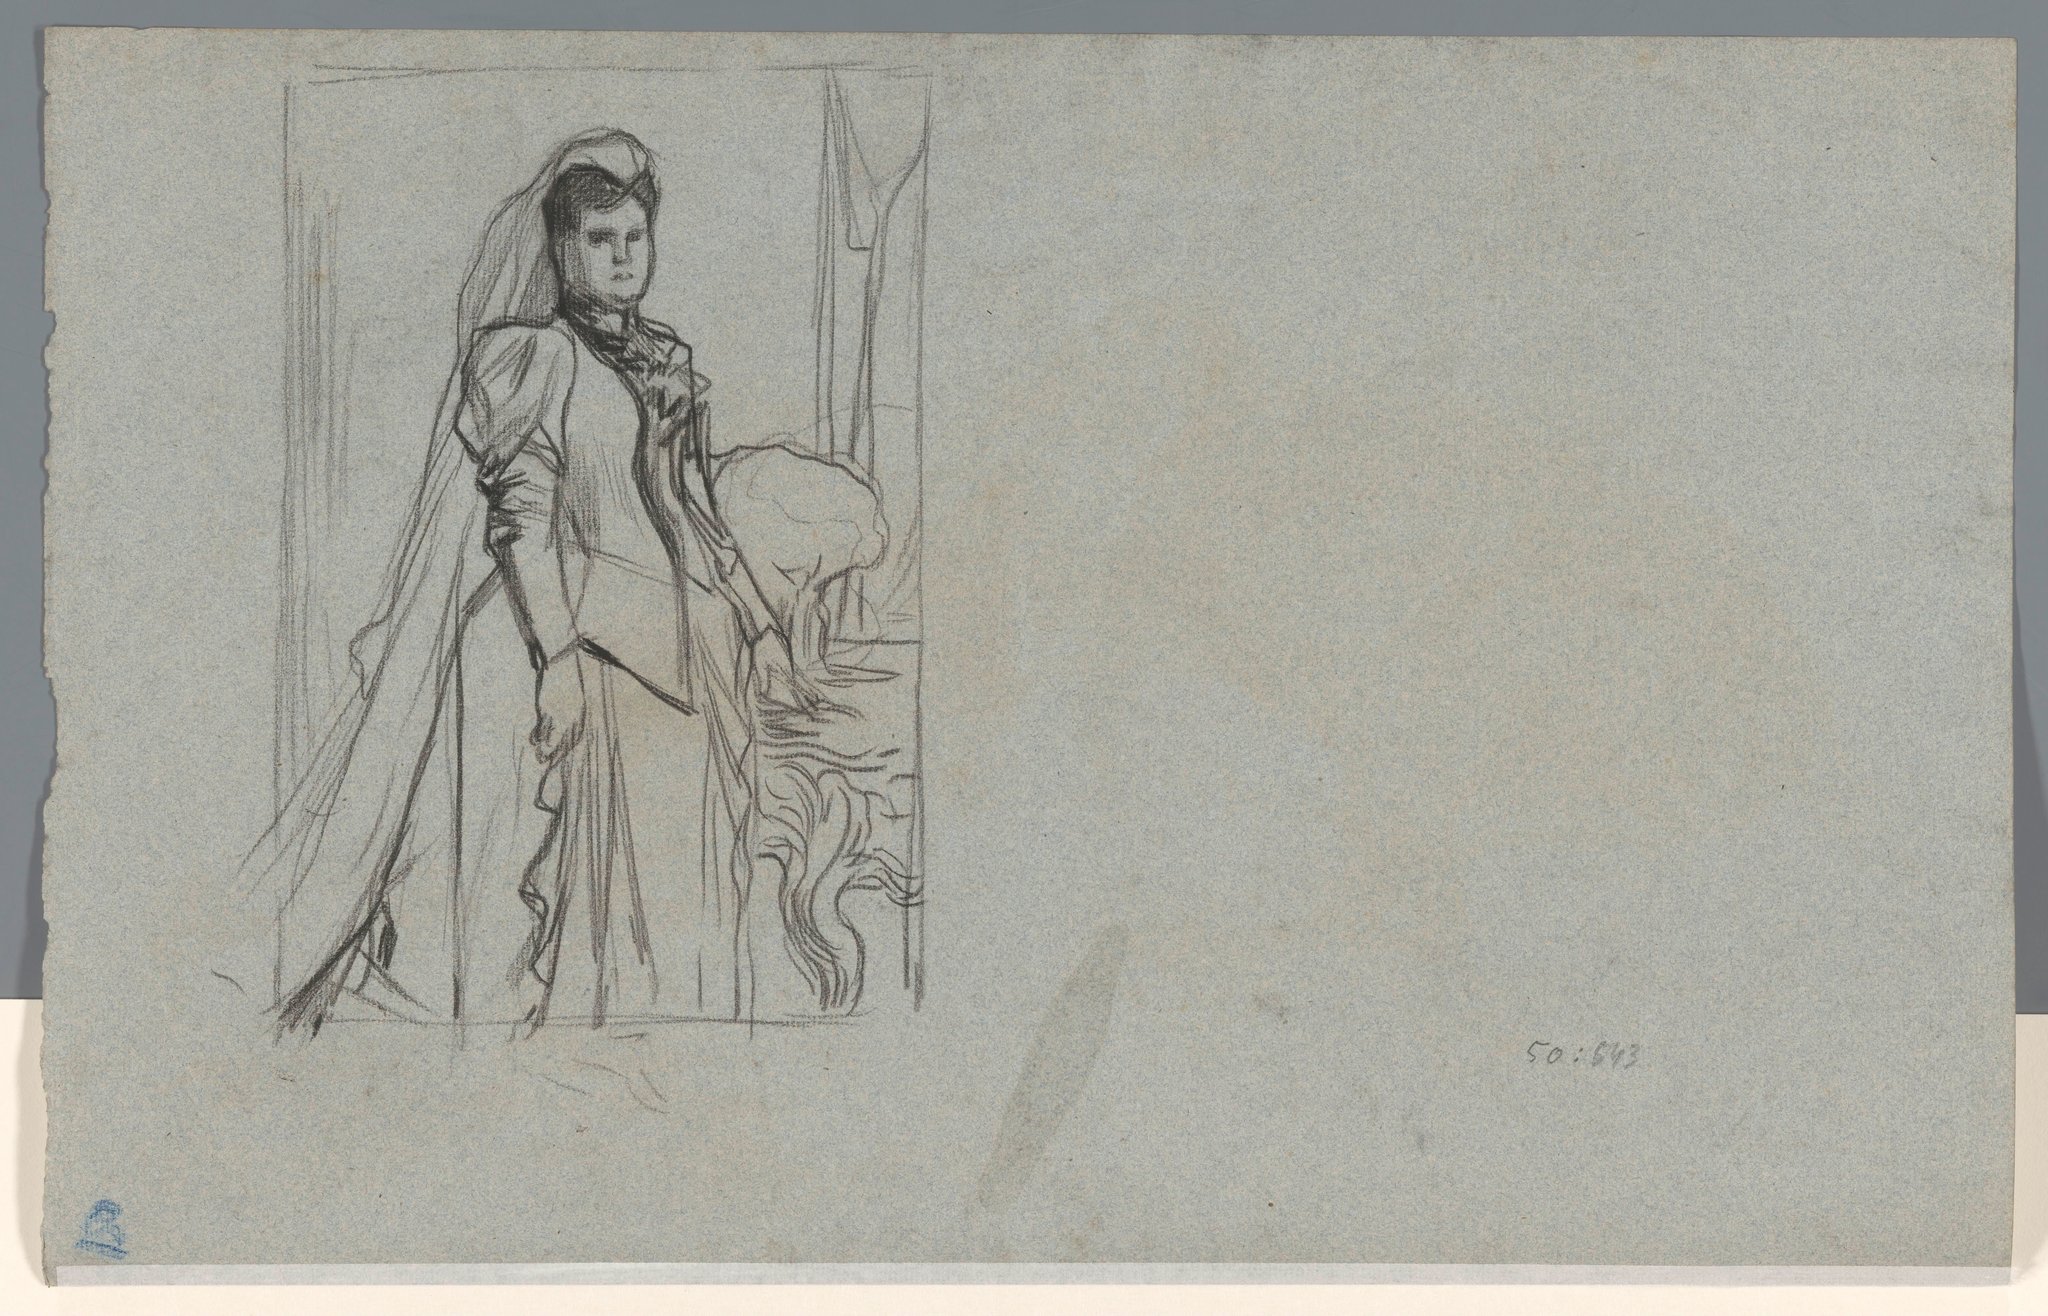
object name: drawing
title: Koningin Emma in weduwendracht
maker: pieter de josselin de jong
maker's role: draughtsman, painter, print maker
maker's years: 1861-1906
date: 1871-1906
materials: chalk, paper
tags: the hague, emma (queen consort of the netherlands), historical persons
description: Voorstudie voor een portret van koningin Emma.